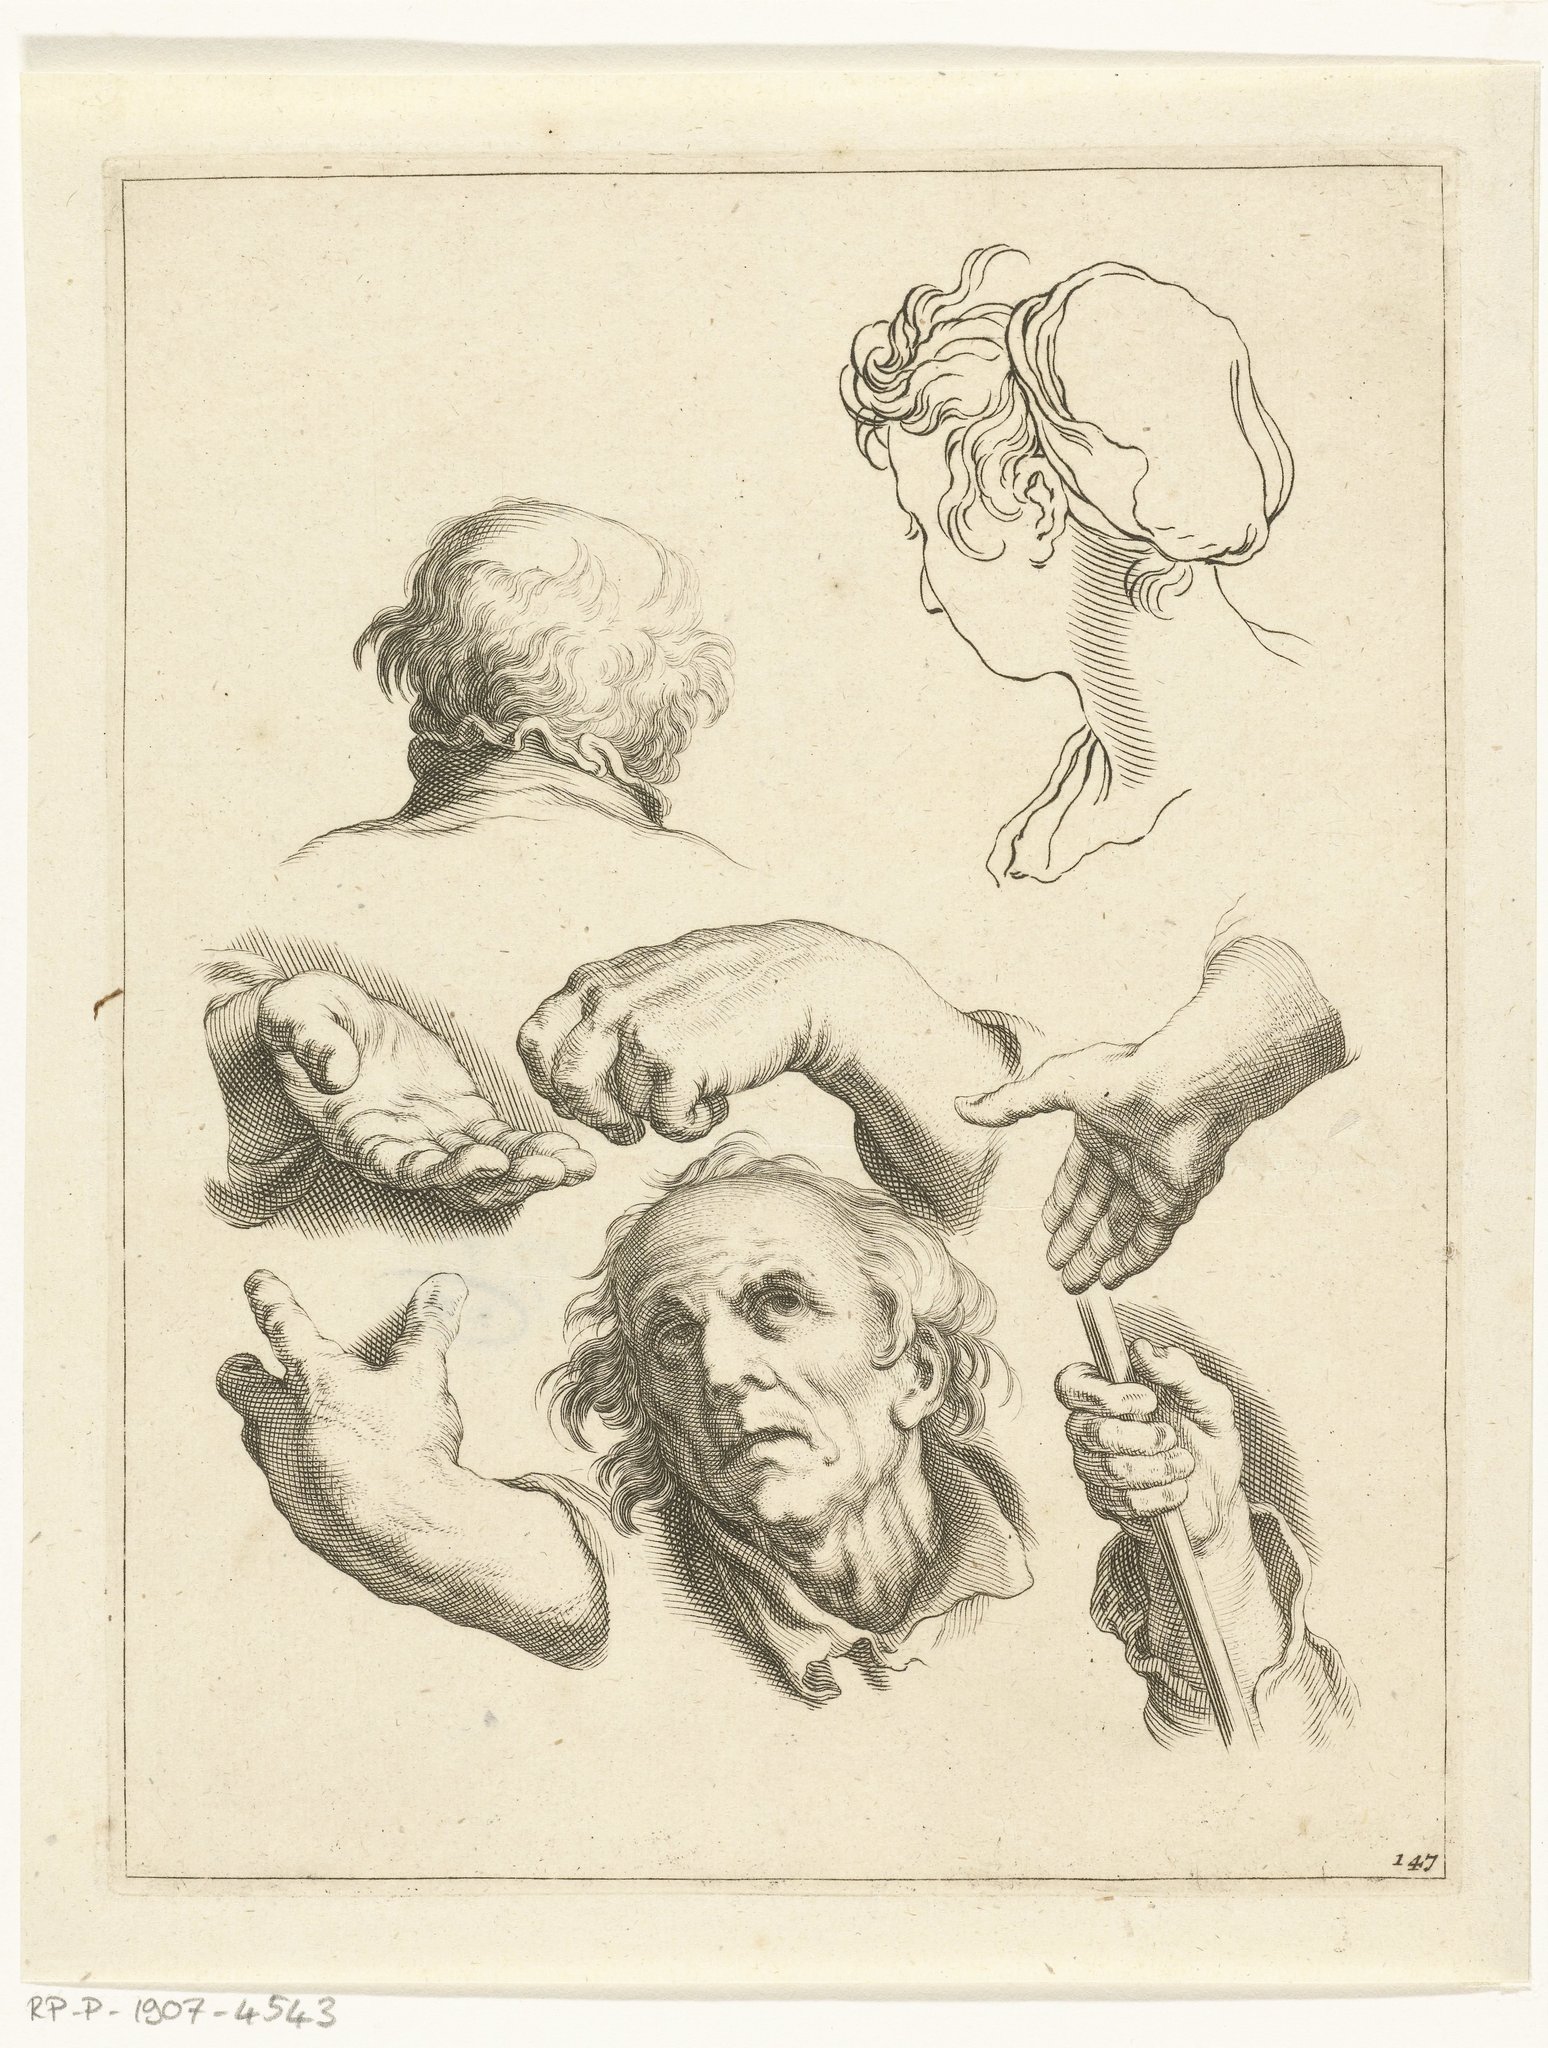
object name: print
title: Hoofden en handen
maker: Anonymous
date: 1679-1750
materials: paper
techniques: engraving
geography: netherlands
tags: monsters of mixed human and animal shape; 'mostri' (ripa) (+ head or (parts of) face)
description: Studie van drie hoofden en vijf handen in verschillende gebaren. Kopie naar een voorstelling uit het tekenboek van Abraham Bloemaert.